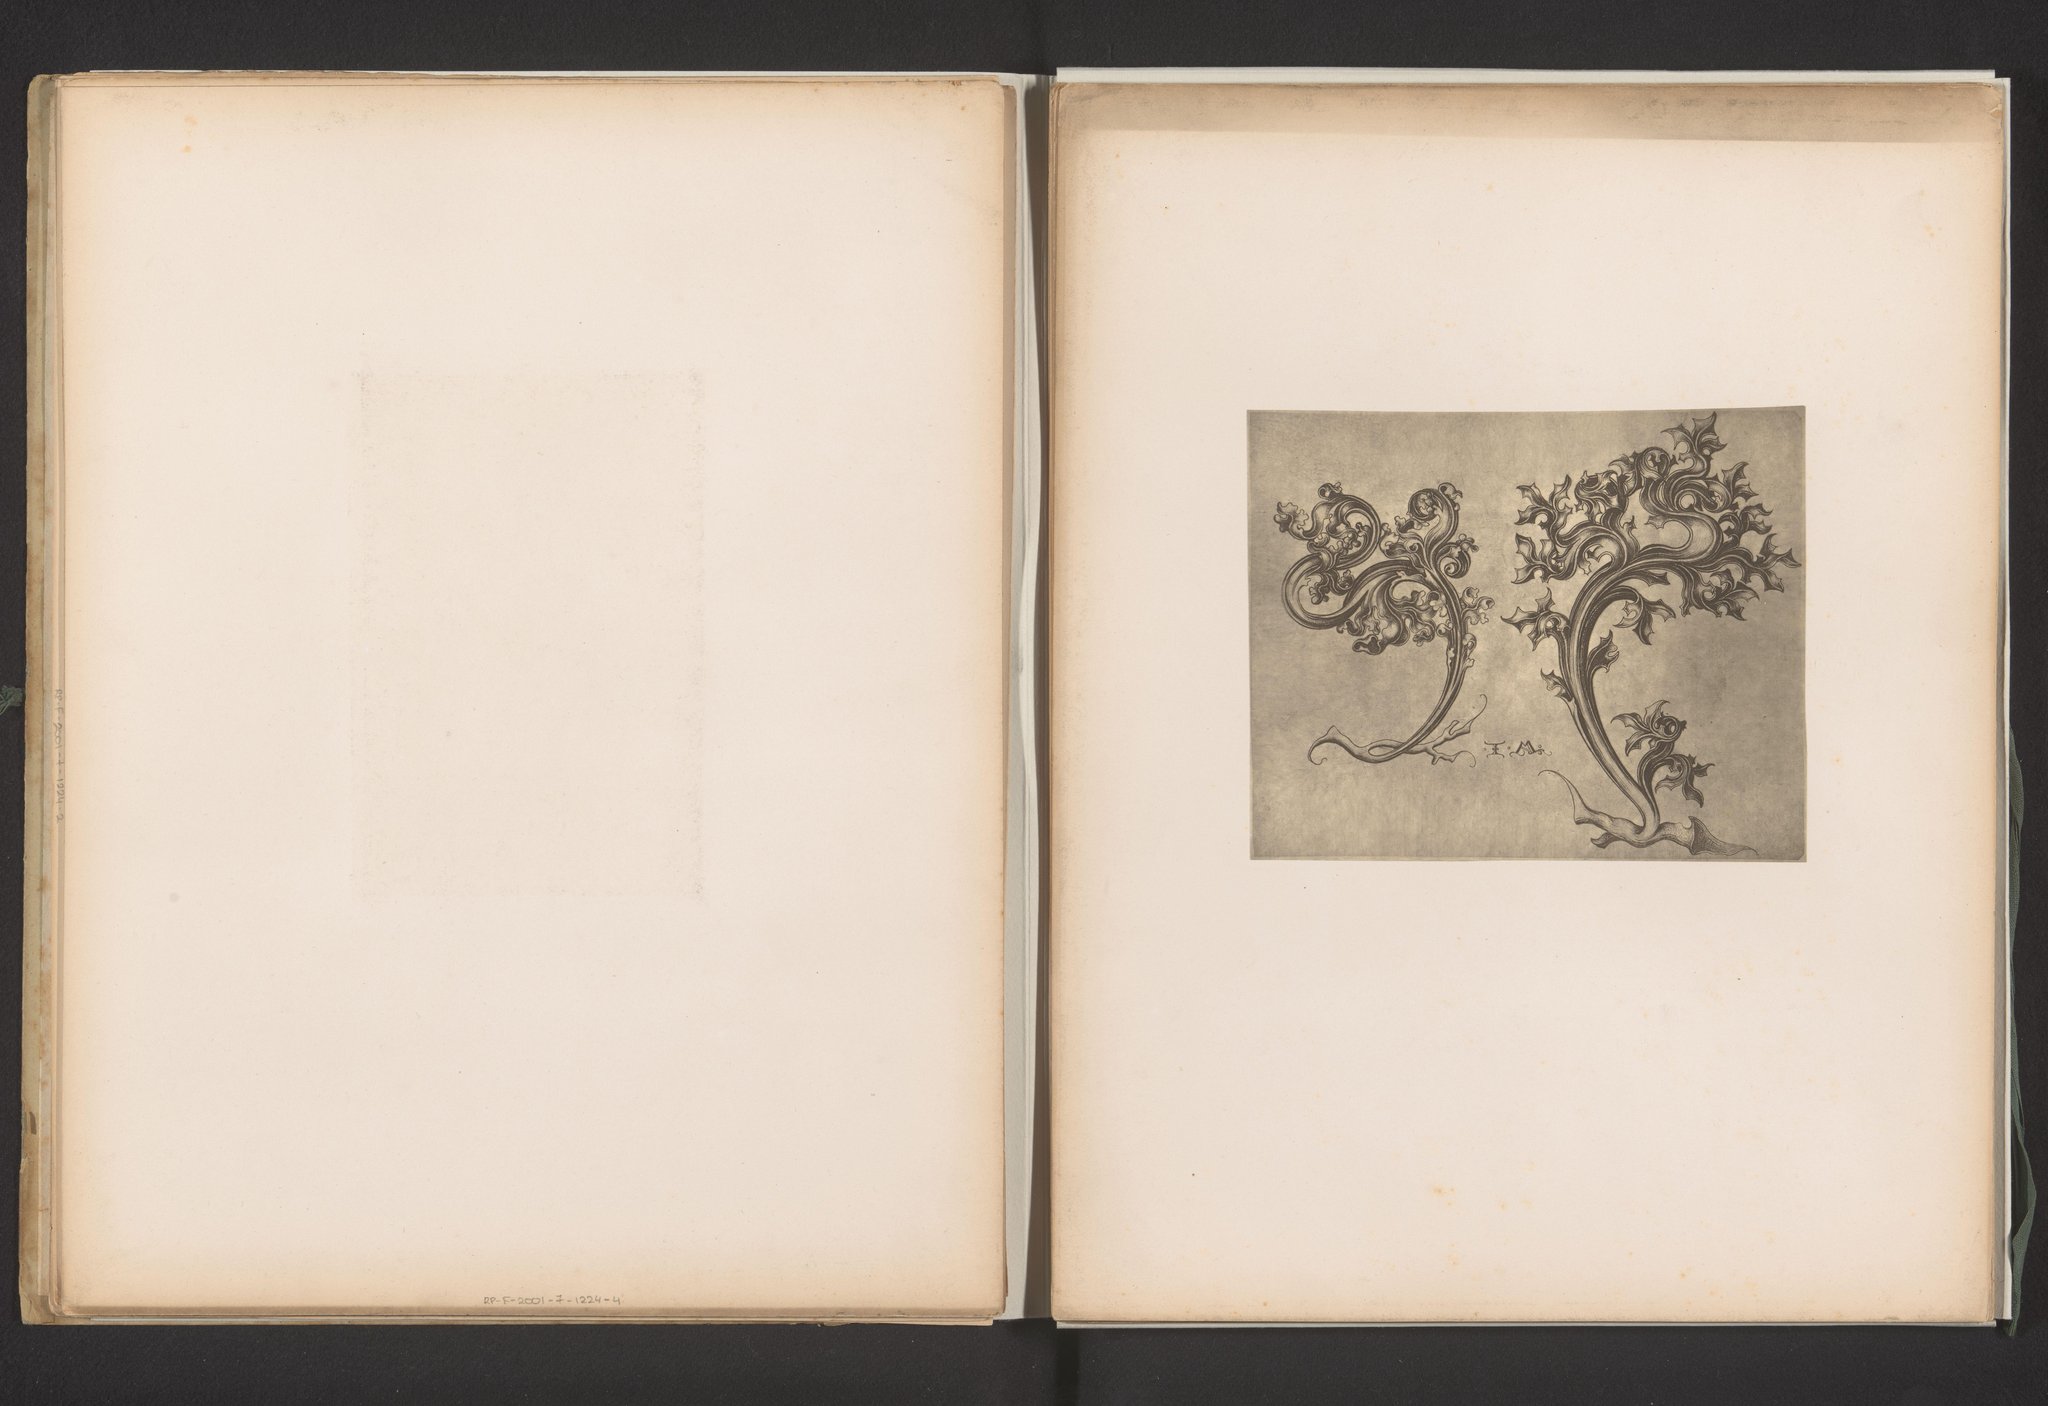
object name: reproduction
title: Reproductie van een prent van twee bladmotieven door Israhel van Meckenem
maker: israhel van meckenem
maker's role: print maker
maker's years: 1440-1517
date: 1867-1872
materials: paper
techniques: woodburytype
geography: brussels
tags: plants; vegetation (+ ornamental variants of plants)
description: Deze prent maakt deel uit van een omslag met 12 prenten op 12 bladen.